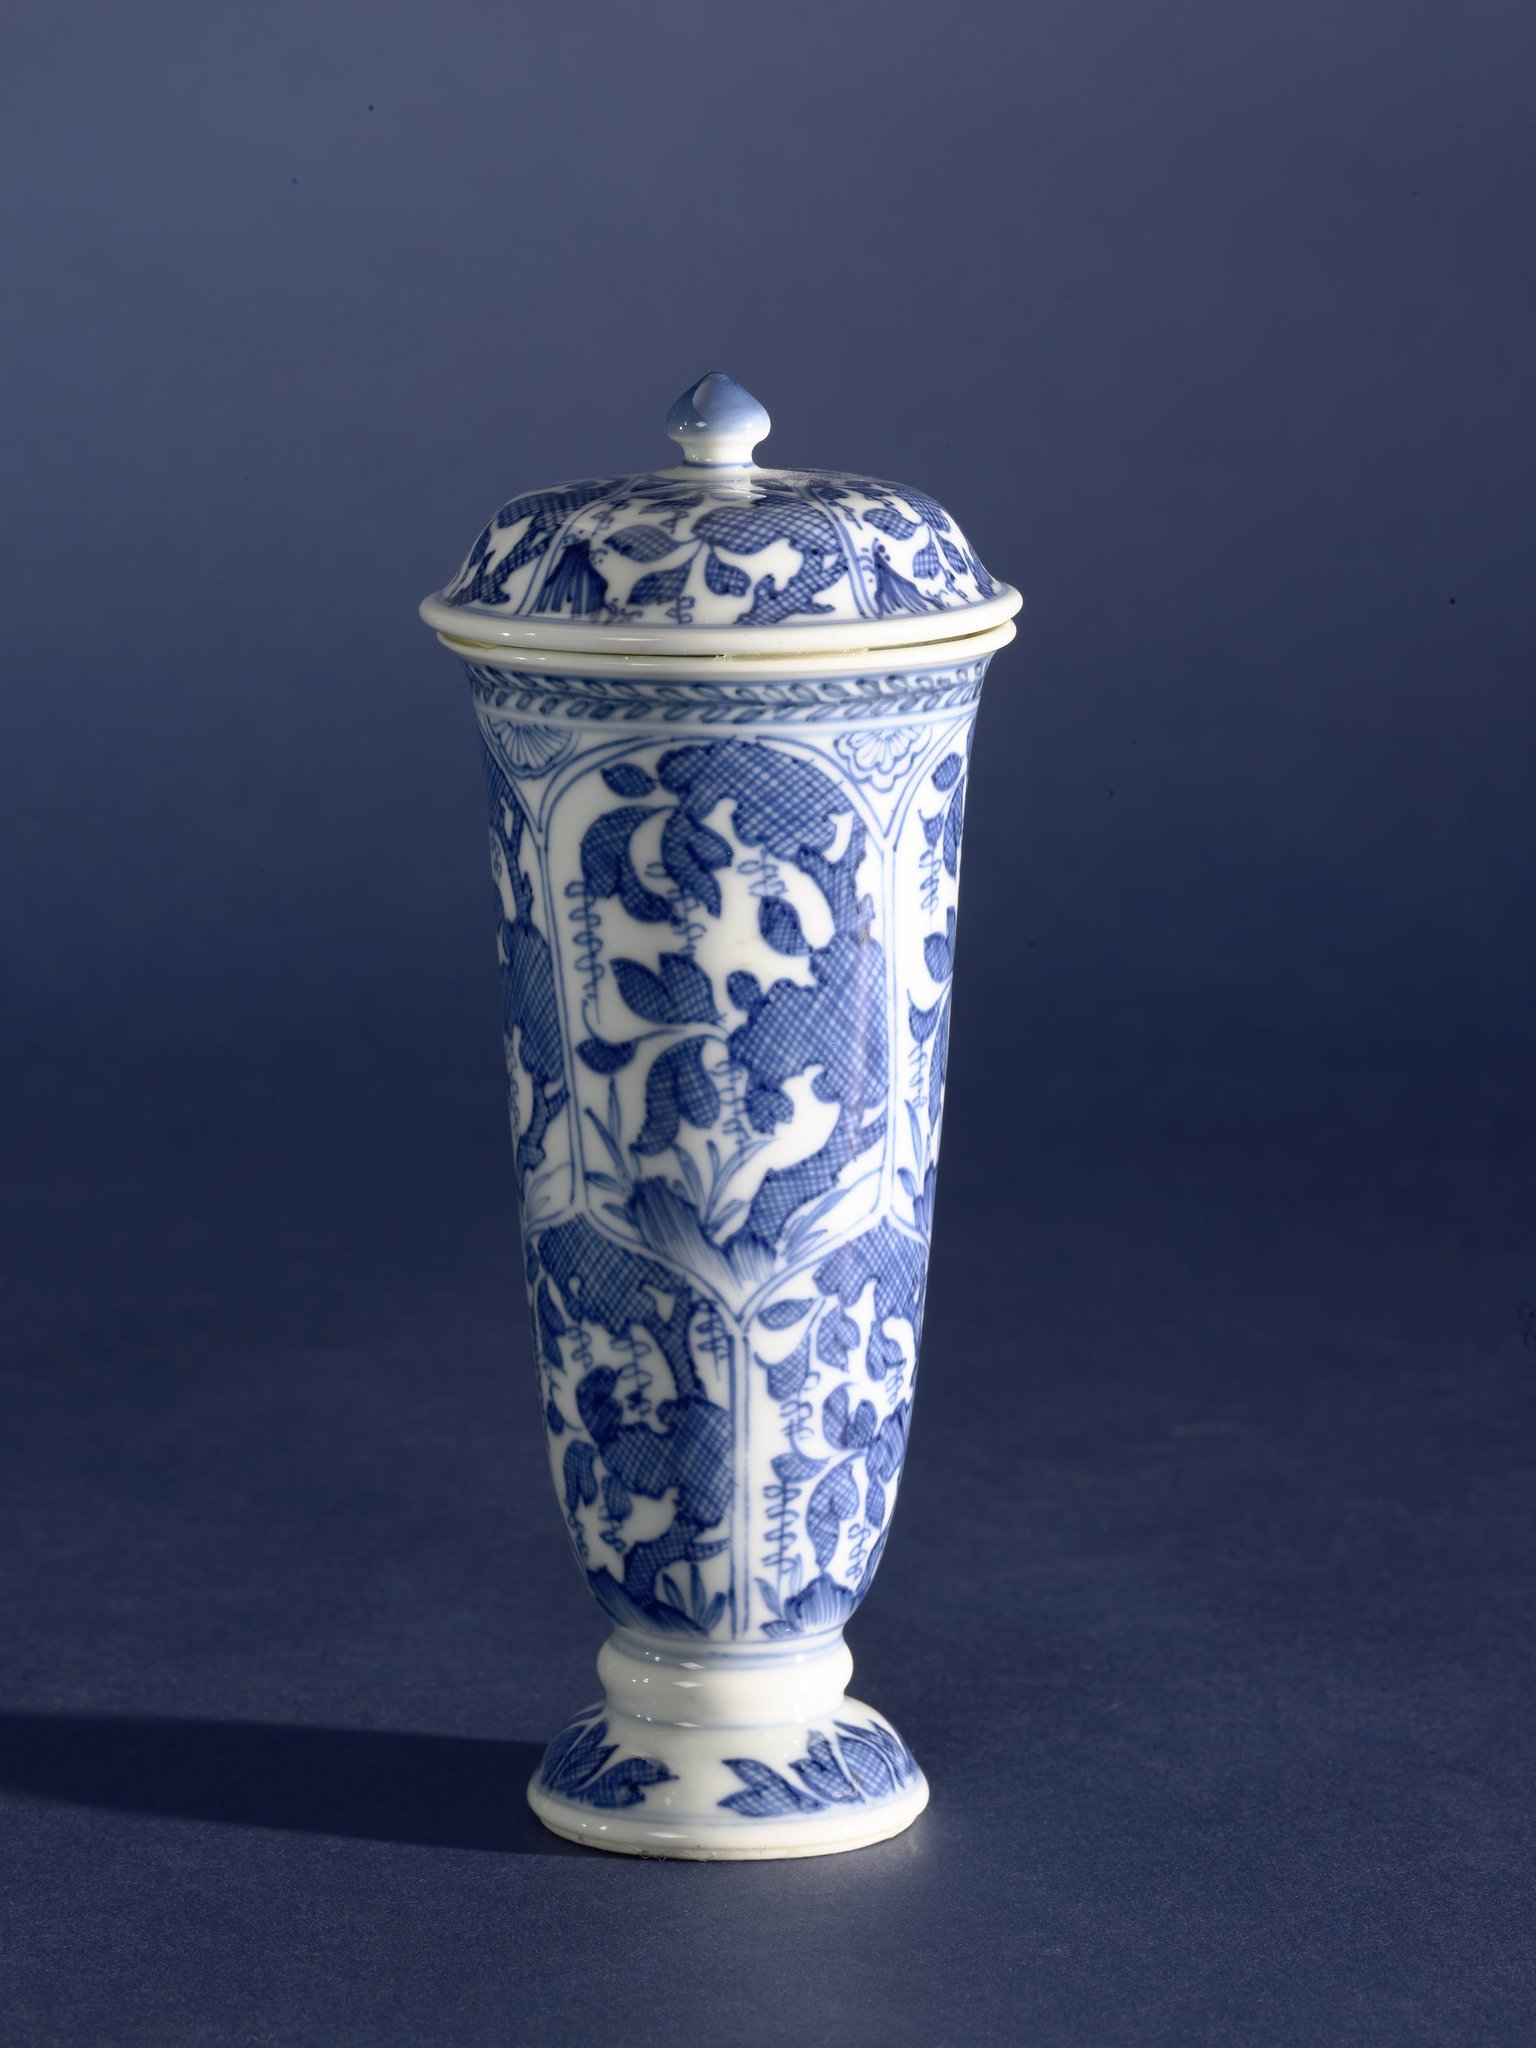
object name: cup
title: Bell-shaped covered beaker vase with hatched plants in petal-shaped panels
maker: Anonymous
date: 1680-1720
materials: cobalt, glaze, paint, porcelain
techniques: firing, turning, vitrification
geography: china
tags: ornament derived from plant forms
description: Beker met deksel op uitspreidende, bolle voet. Tussen de voet en het lichaam een smallere, bolle band. Lang lichaam met licht spreidende rand en bolvormige deksel met knop. Gedecoreerd in onderglazuur blauw met twee rijen van vier lotusvormige velden, die zijn gevuld met gearceerde bebladerde takken. Rondom de mond een bladrand.